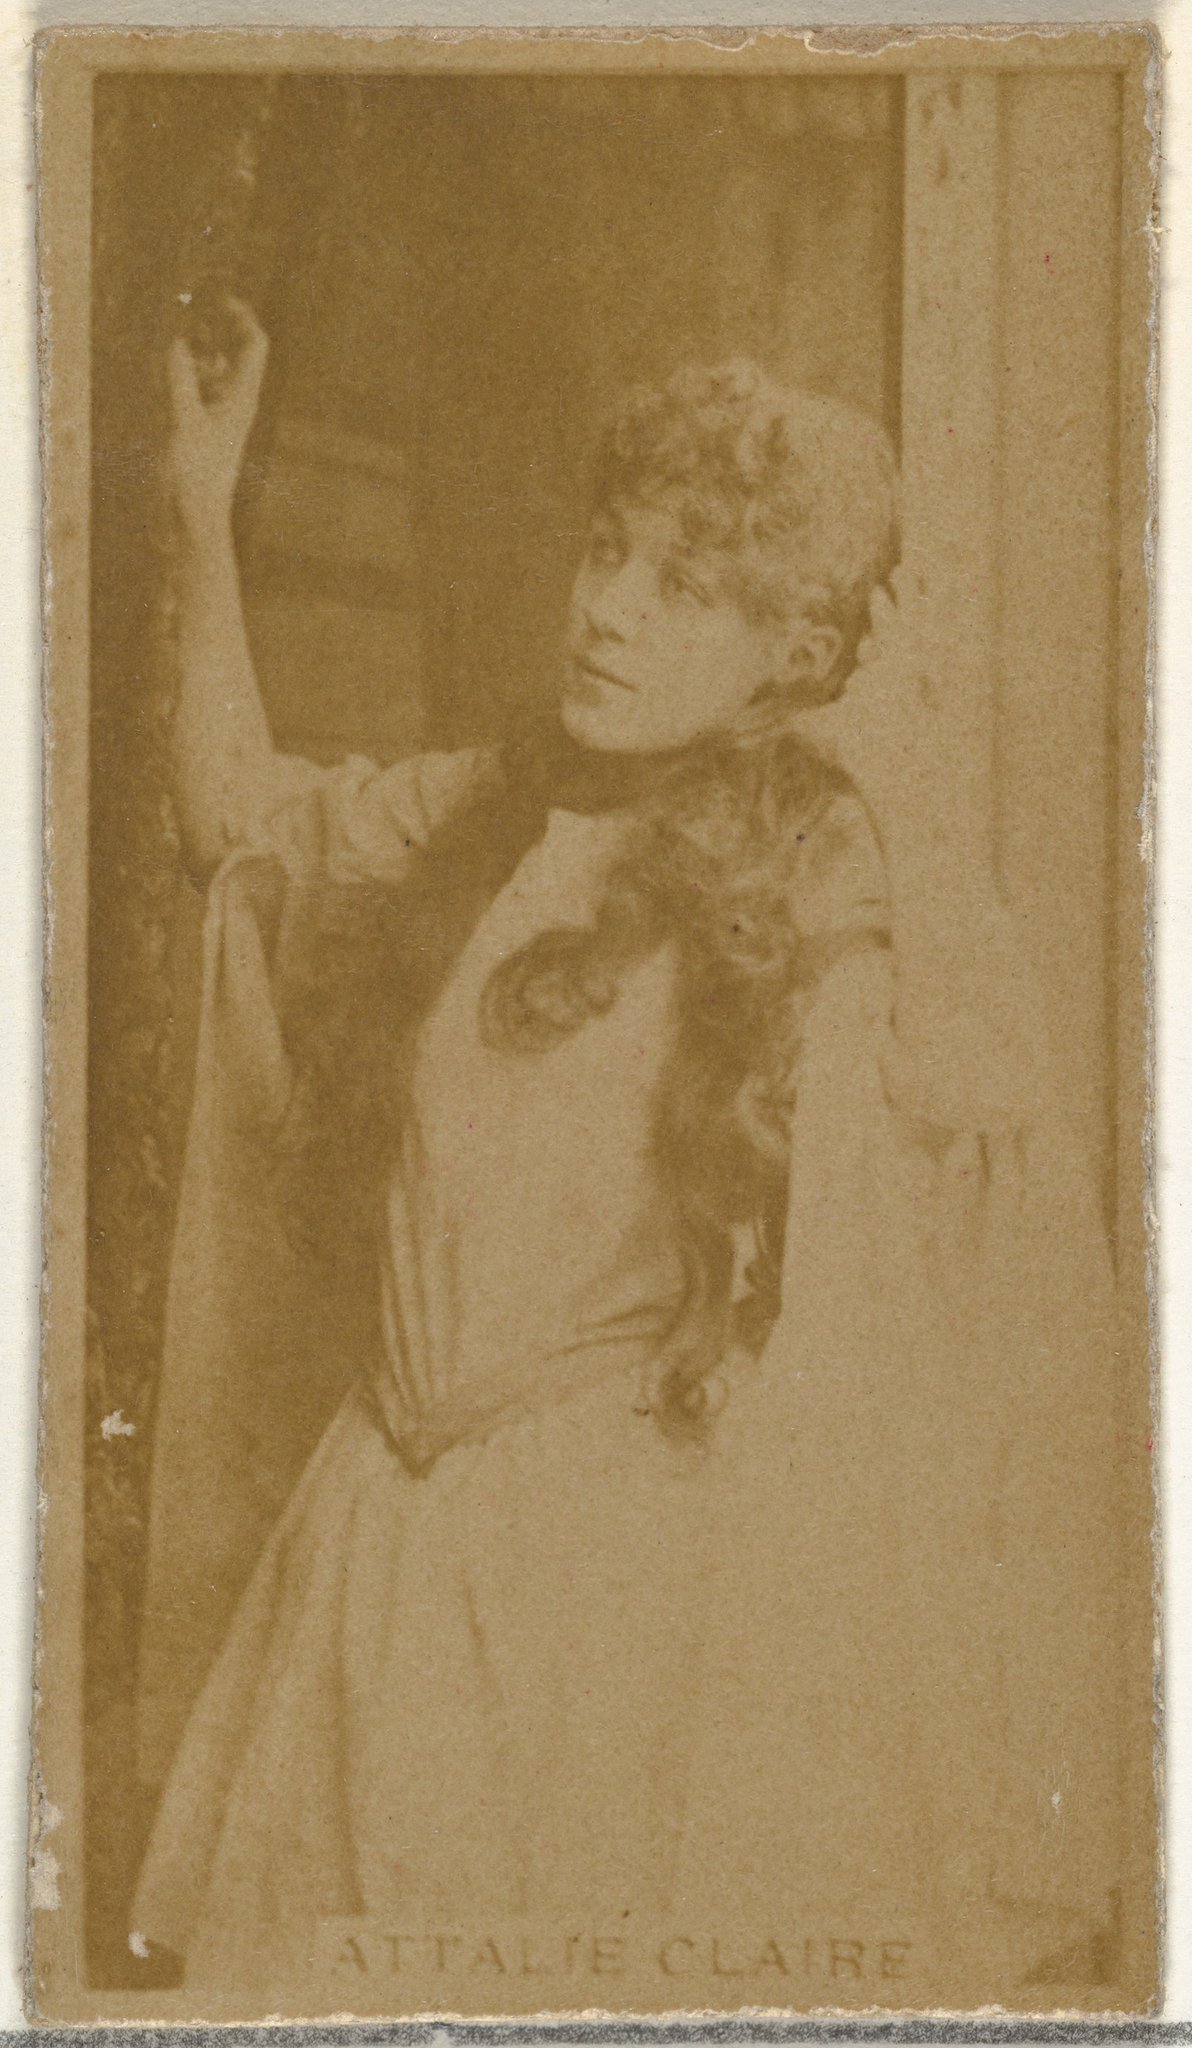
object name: photograph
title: Attalie Claire, from the Actors and Actresses series (N145-8) issued by Duke Sons & Co. to promote Duke Cigarettes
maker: w. duke, sons & co.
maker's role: publisher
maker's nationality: american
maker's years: 1870-1920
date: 1891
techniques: albumen silver print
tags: portraits,women,actresses